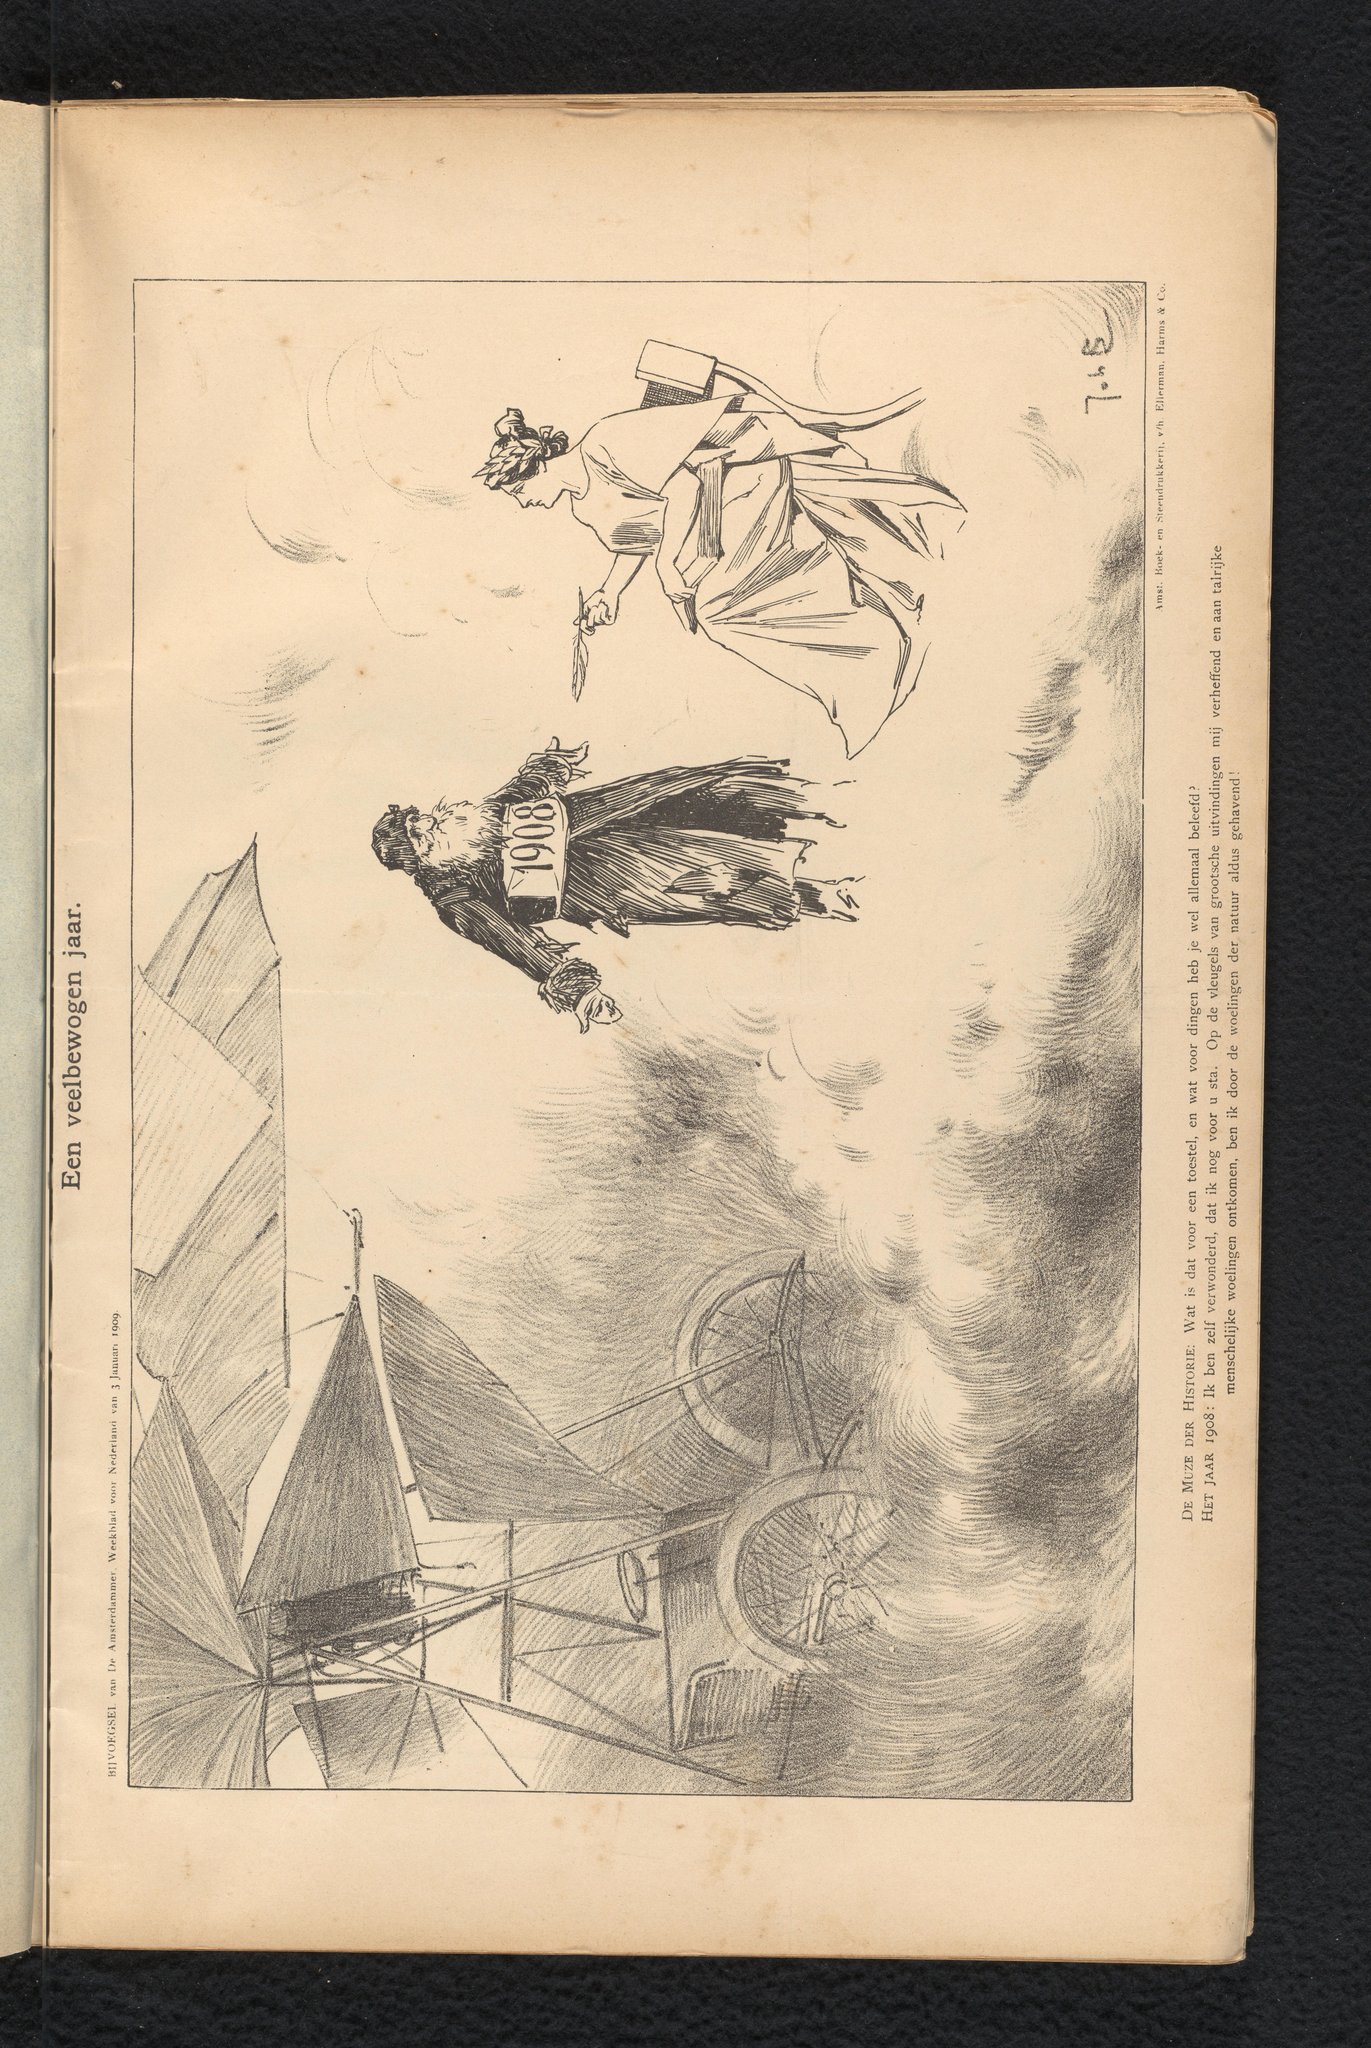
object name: cartoon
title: Een veelbewogen jaar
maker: johan braakensiek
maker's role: draughtsman, print maker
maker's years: 1858-1940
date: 1909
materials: paper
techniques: lithograph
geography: netherlands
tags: aircraft, aeroplane, new year's eve (december 31), old man, clio (one of the muses); 'clio' (ripa), political caricatures and satires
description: De oude man van het jaar 1908 met een vliegtuig gekomen staande voor de muze Clio die de historie schrijft.